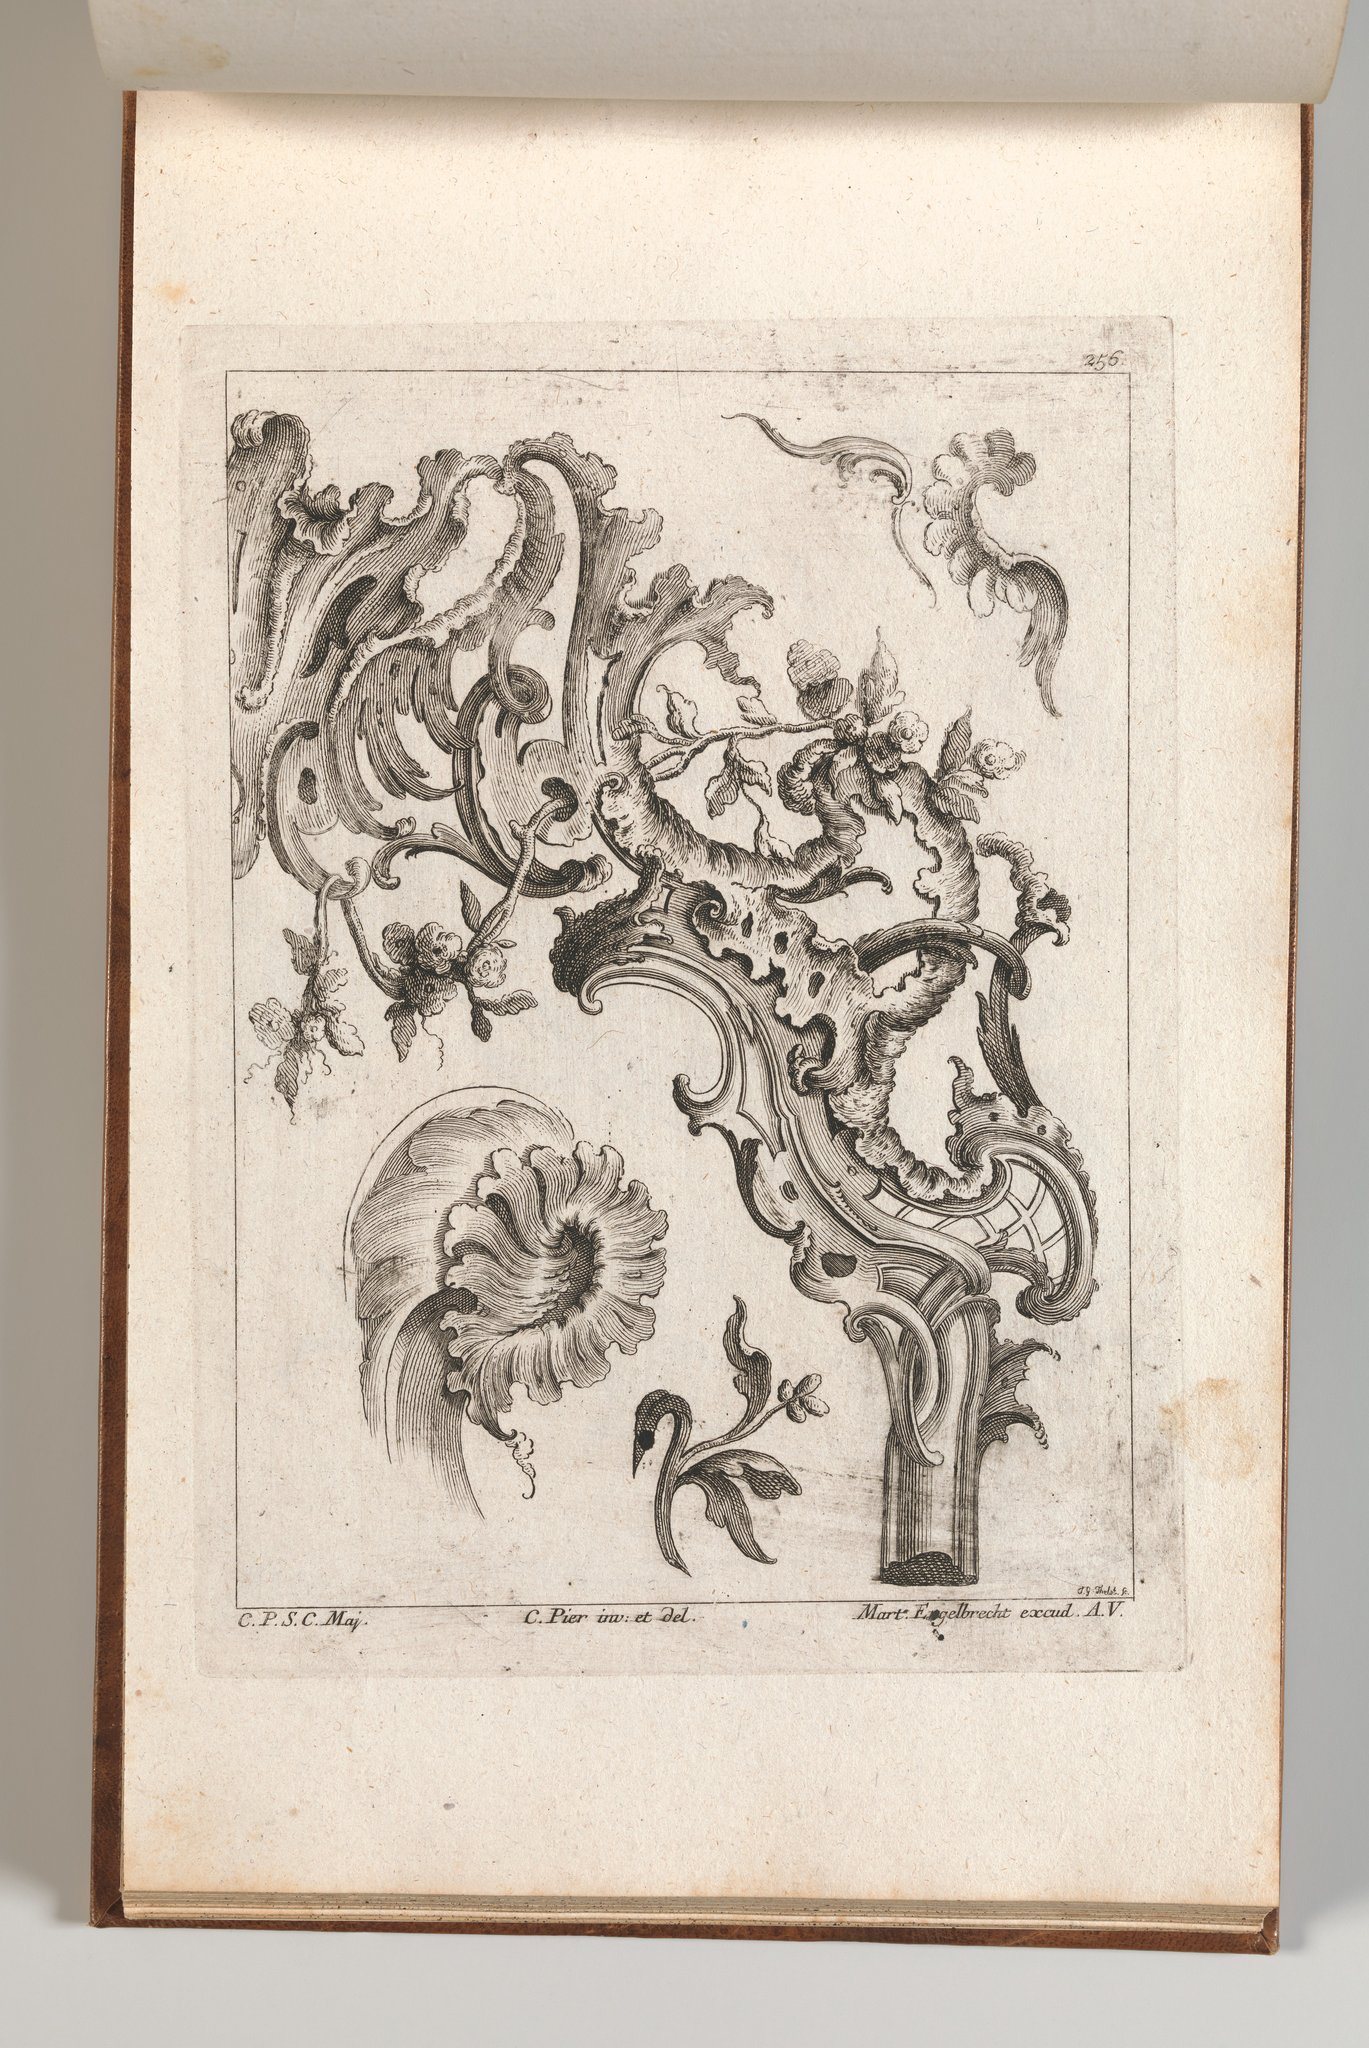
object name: album print ornament architecture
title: Various Designs for Rocaille Ornaments, Plate 3 from an Untitled Series of Rocaille Ornaments for Frames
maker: jacob gottlieb thelot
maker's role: engraver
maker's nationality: central european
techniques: etching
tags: ornament